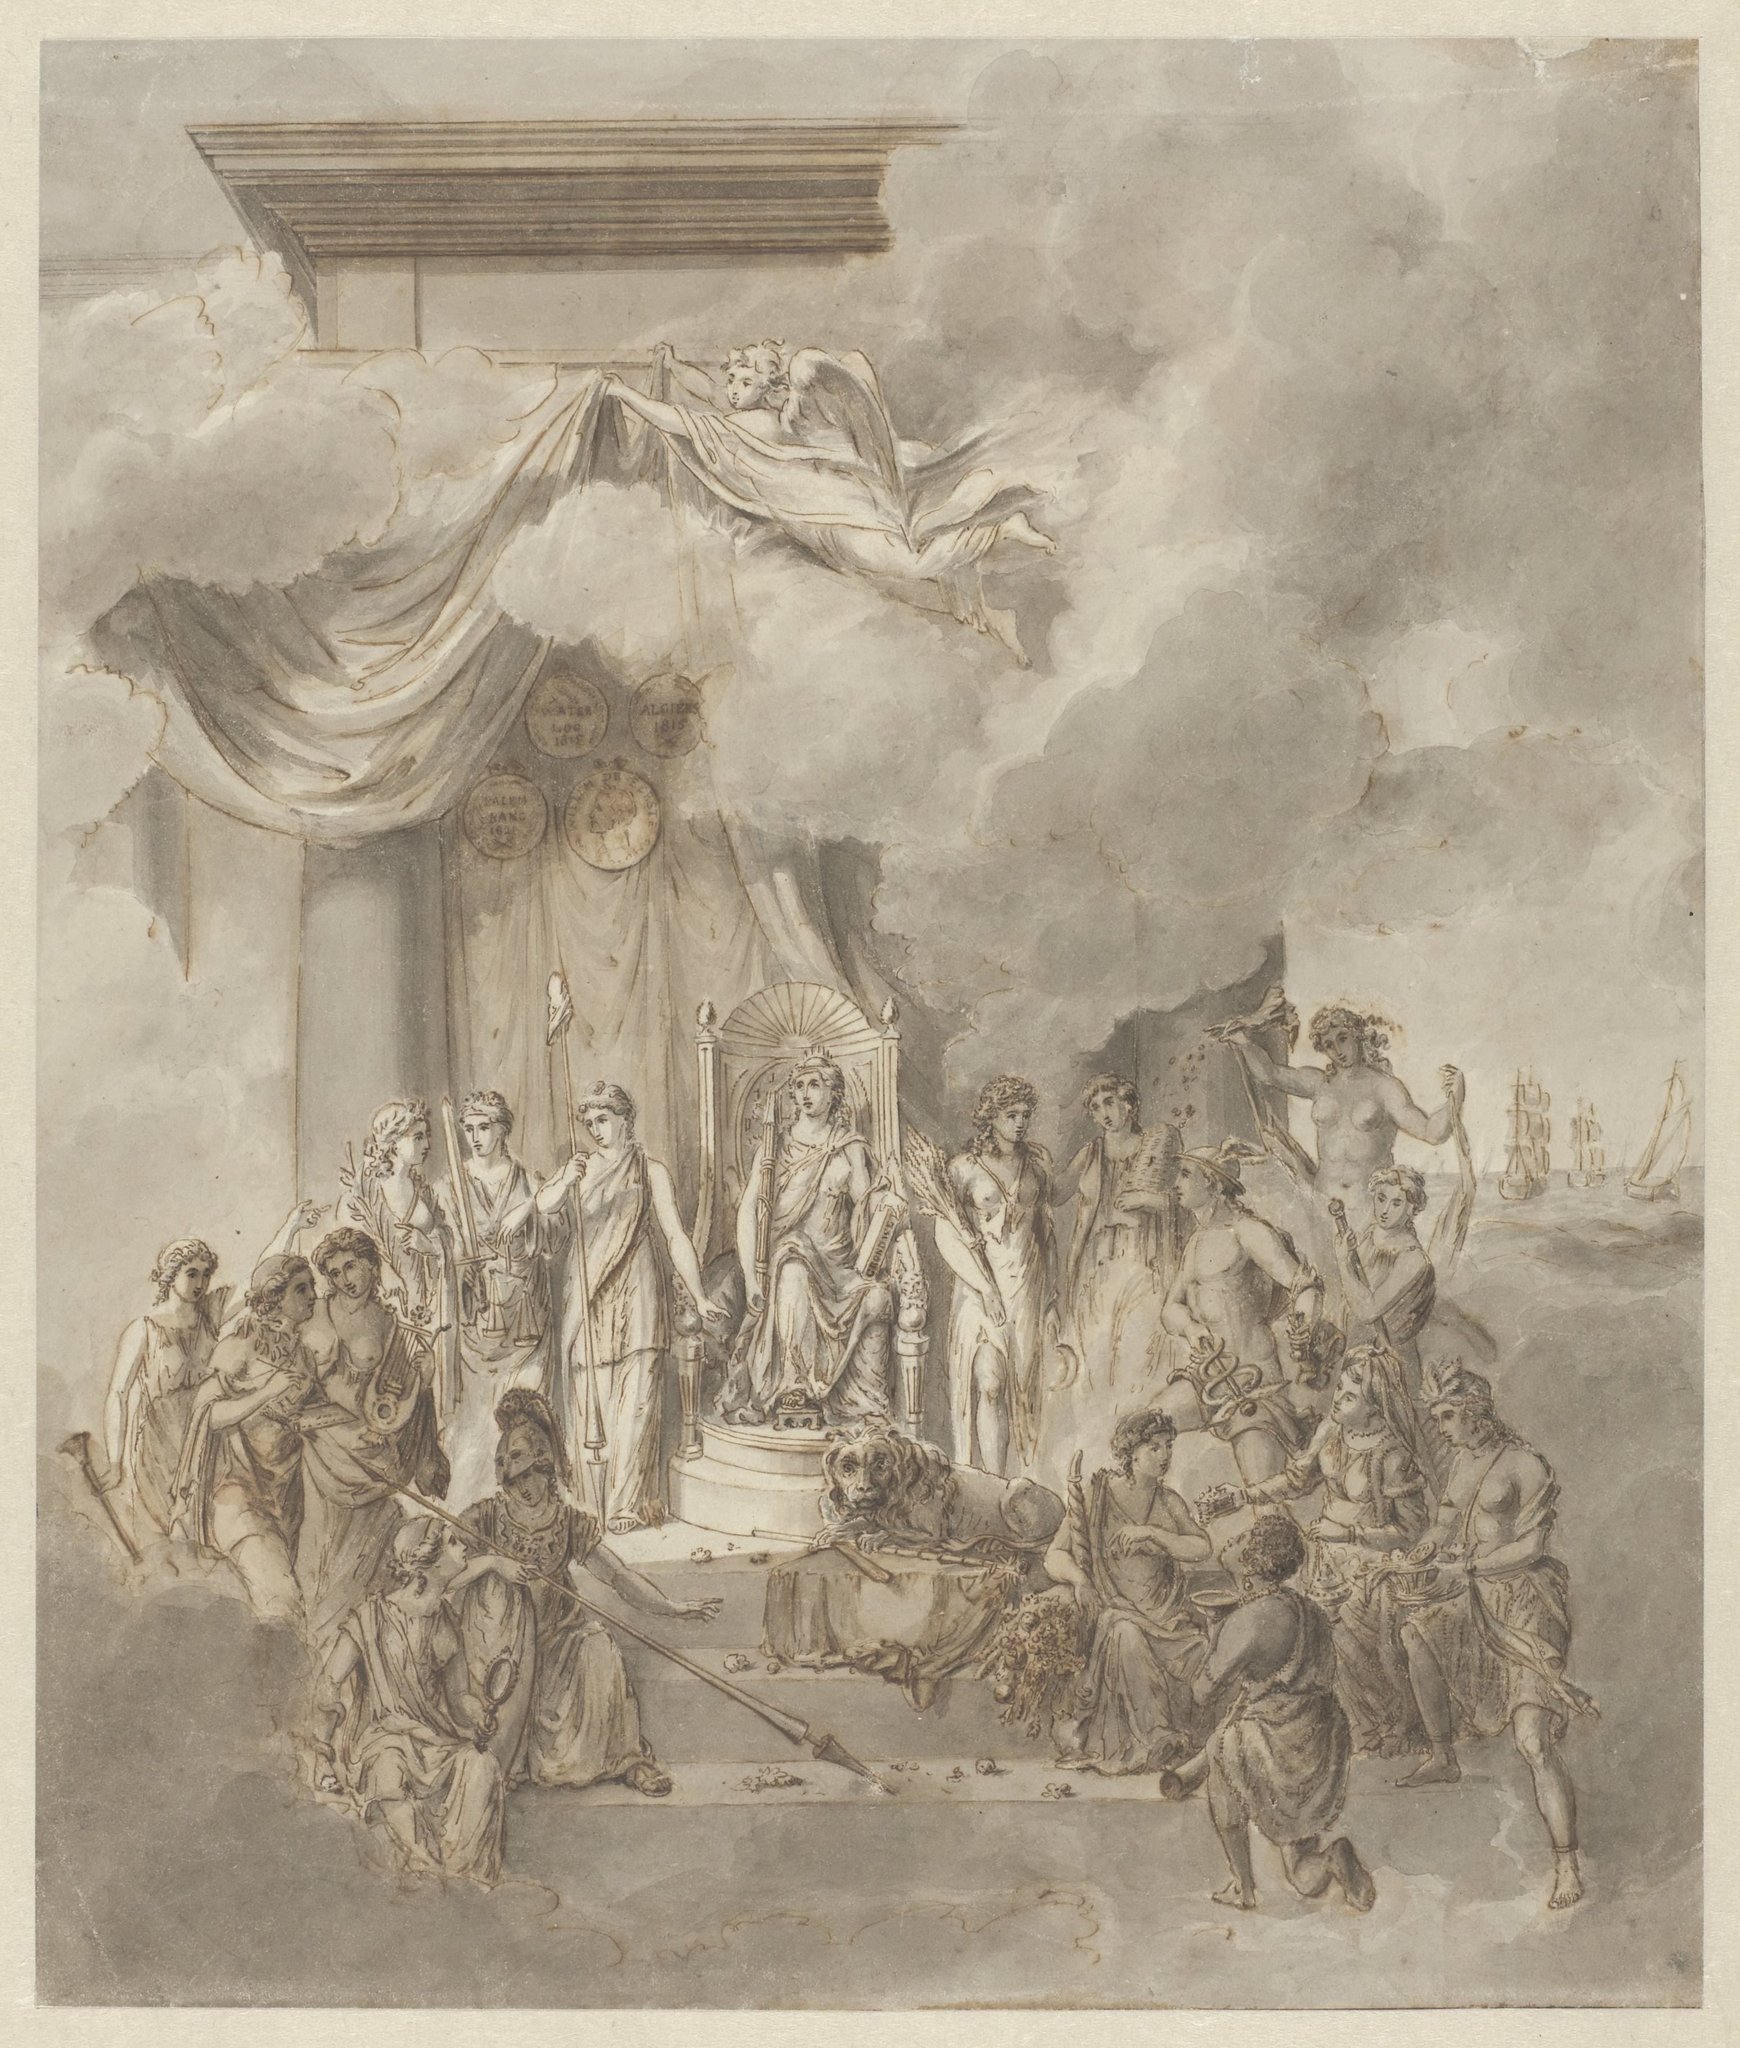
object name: drawing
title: Allegorie op de regering van koning Willem I, 1838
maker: Anonymous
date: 1838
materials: ink, paper, pencil, watercolor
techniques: brush, pen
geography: netherlands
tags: the hague, berlin, william i of the netherlands, minerva as patroness, justice, 'justitia'; 'giustitia divina' (ripa) ~ one of the four cardinal virtues, prudence, 'prudentia'; 'prudenza' (ripa) ~ one of the four cardinal virtues, virtues of the ruler, 'pictura', symbolic representations, allegories and emblems ~ painting; 'pittura' (ripa), personifications of countries, nations, states, districts, etc., art, asia represented allegorically; 'asia' (ripa), africa represented allegorically; 'africa' (ripa), america represented allegorically; 'america' (ripa), industriousness, assiduity; 'assiduità', 'industria', 'zelo' (ripa), abundance; 'abondanza', 'abondanza maritima' (ripa), justice; 'forza alla giustitia sottoposta', 'giustitia', 'giustitia retta', 'giustitia rigorosa', 'impietà e violenza soggetta alla giustitia' (ripa), personification of agriculture, 'agricultura'; 'agricoltura', 'studio dell'agricoltura' (ripa), luck, fortune, lot; 'fato', 'fortuna', 'fortuna aurea', 'fortuna buona', 'fortuna pacifica overo clemente', 'sorte' (ripa), precaution, fame; 'fama', 'fama buona', 'fama chiara' (ripa), freedom, liberty; 'libertà' (ripa), specific aspects, allegorical aspects of mercury; mercury as patron, beasts of prey, predatory animals: lion, good government, netherlands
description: Allegorie, waarschijnlijk bij de 25-jarige regering van koning Willem I in 1838.